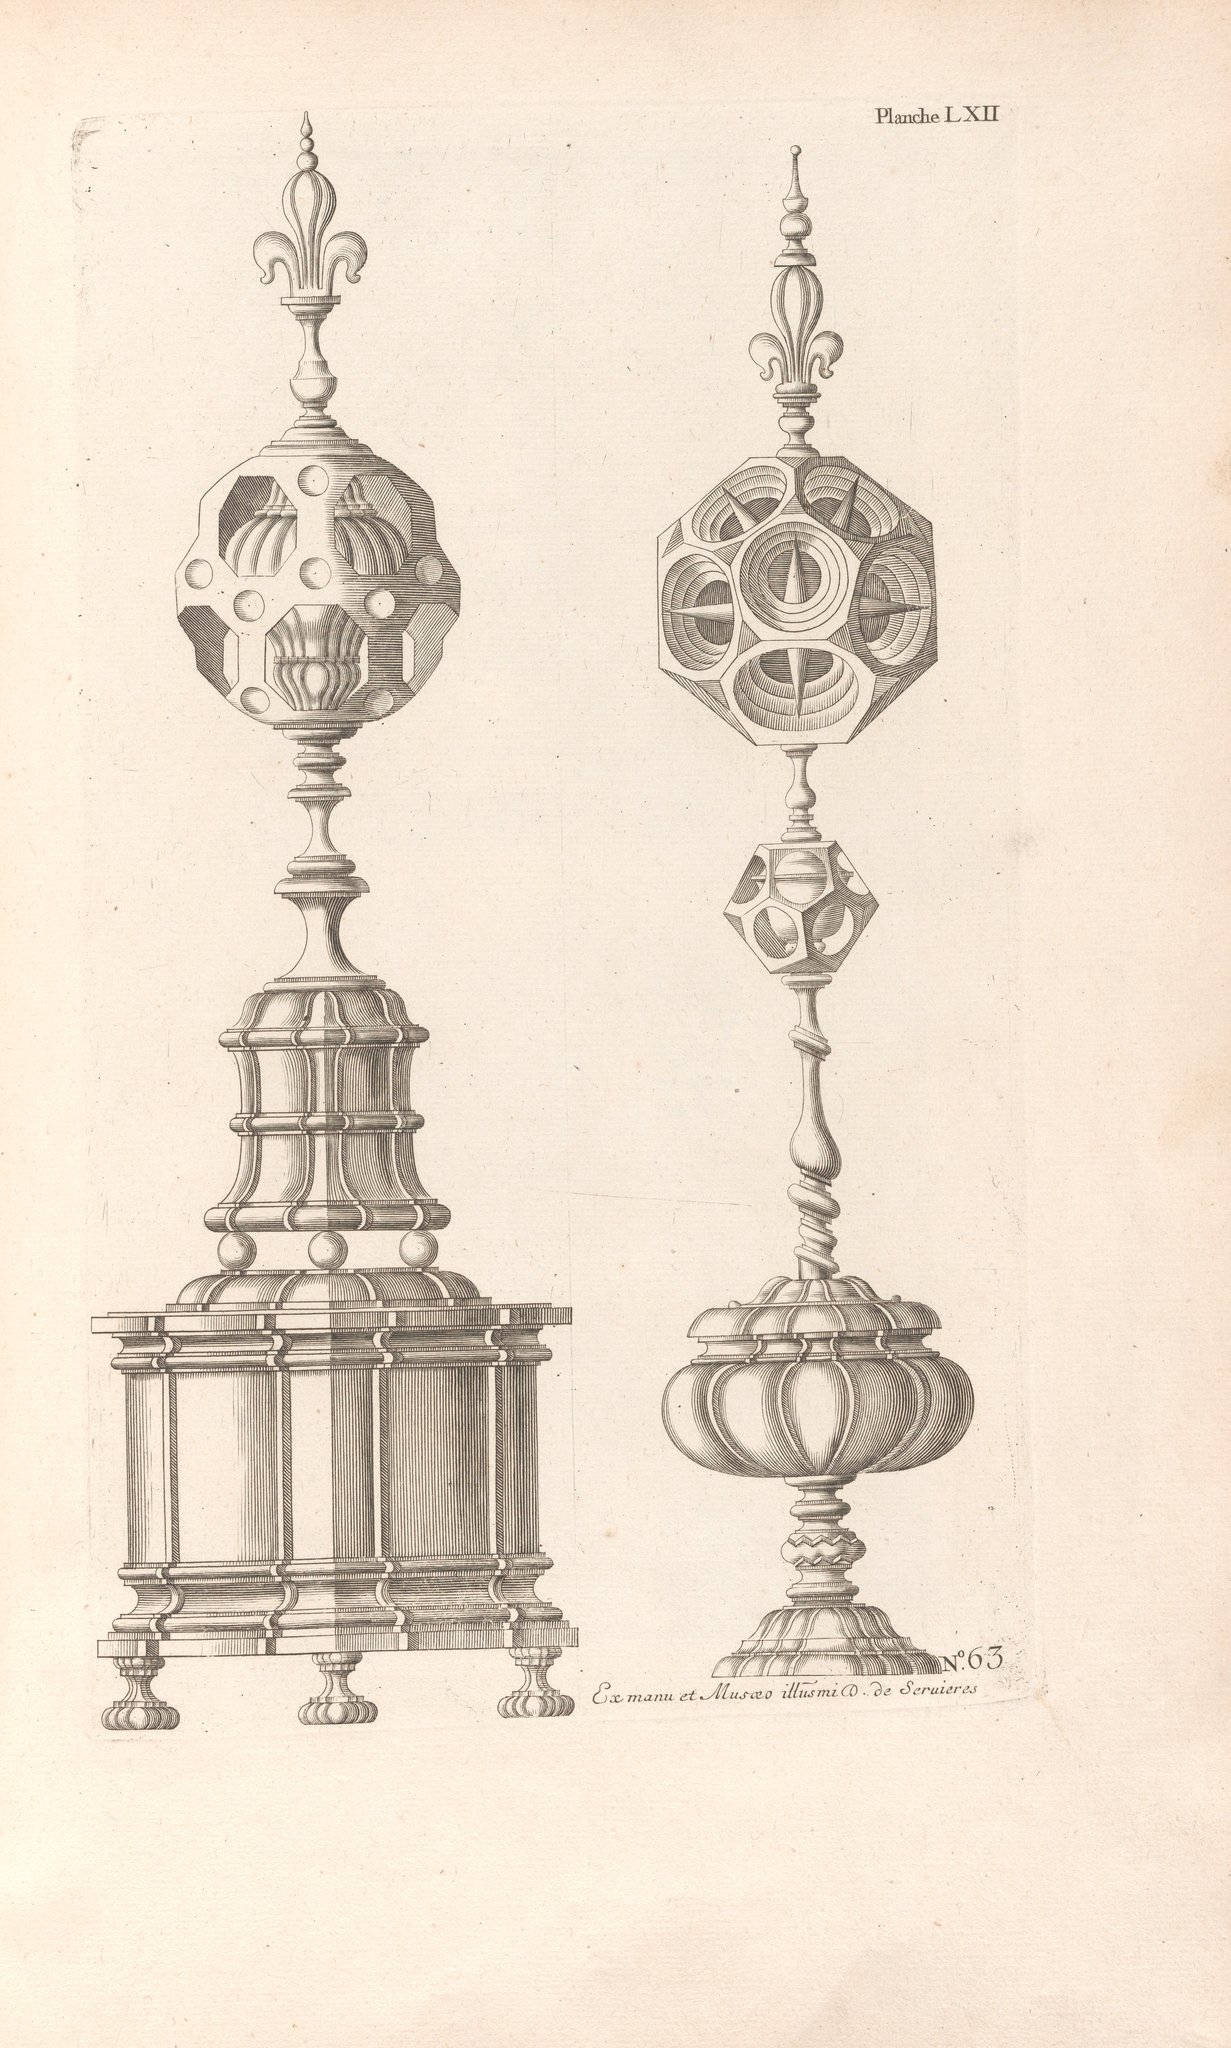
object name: book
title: L'Art de Tourner, ou de faire en perfection toutes sortes d'ouvrages au tour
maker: charles plumier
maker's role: author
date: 1749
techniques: engraving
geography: france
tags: hands